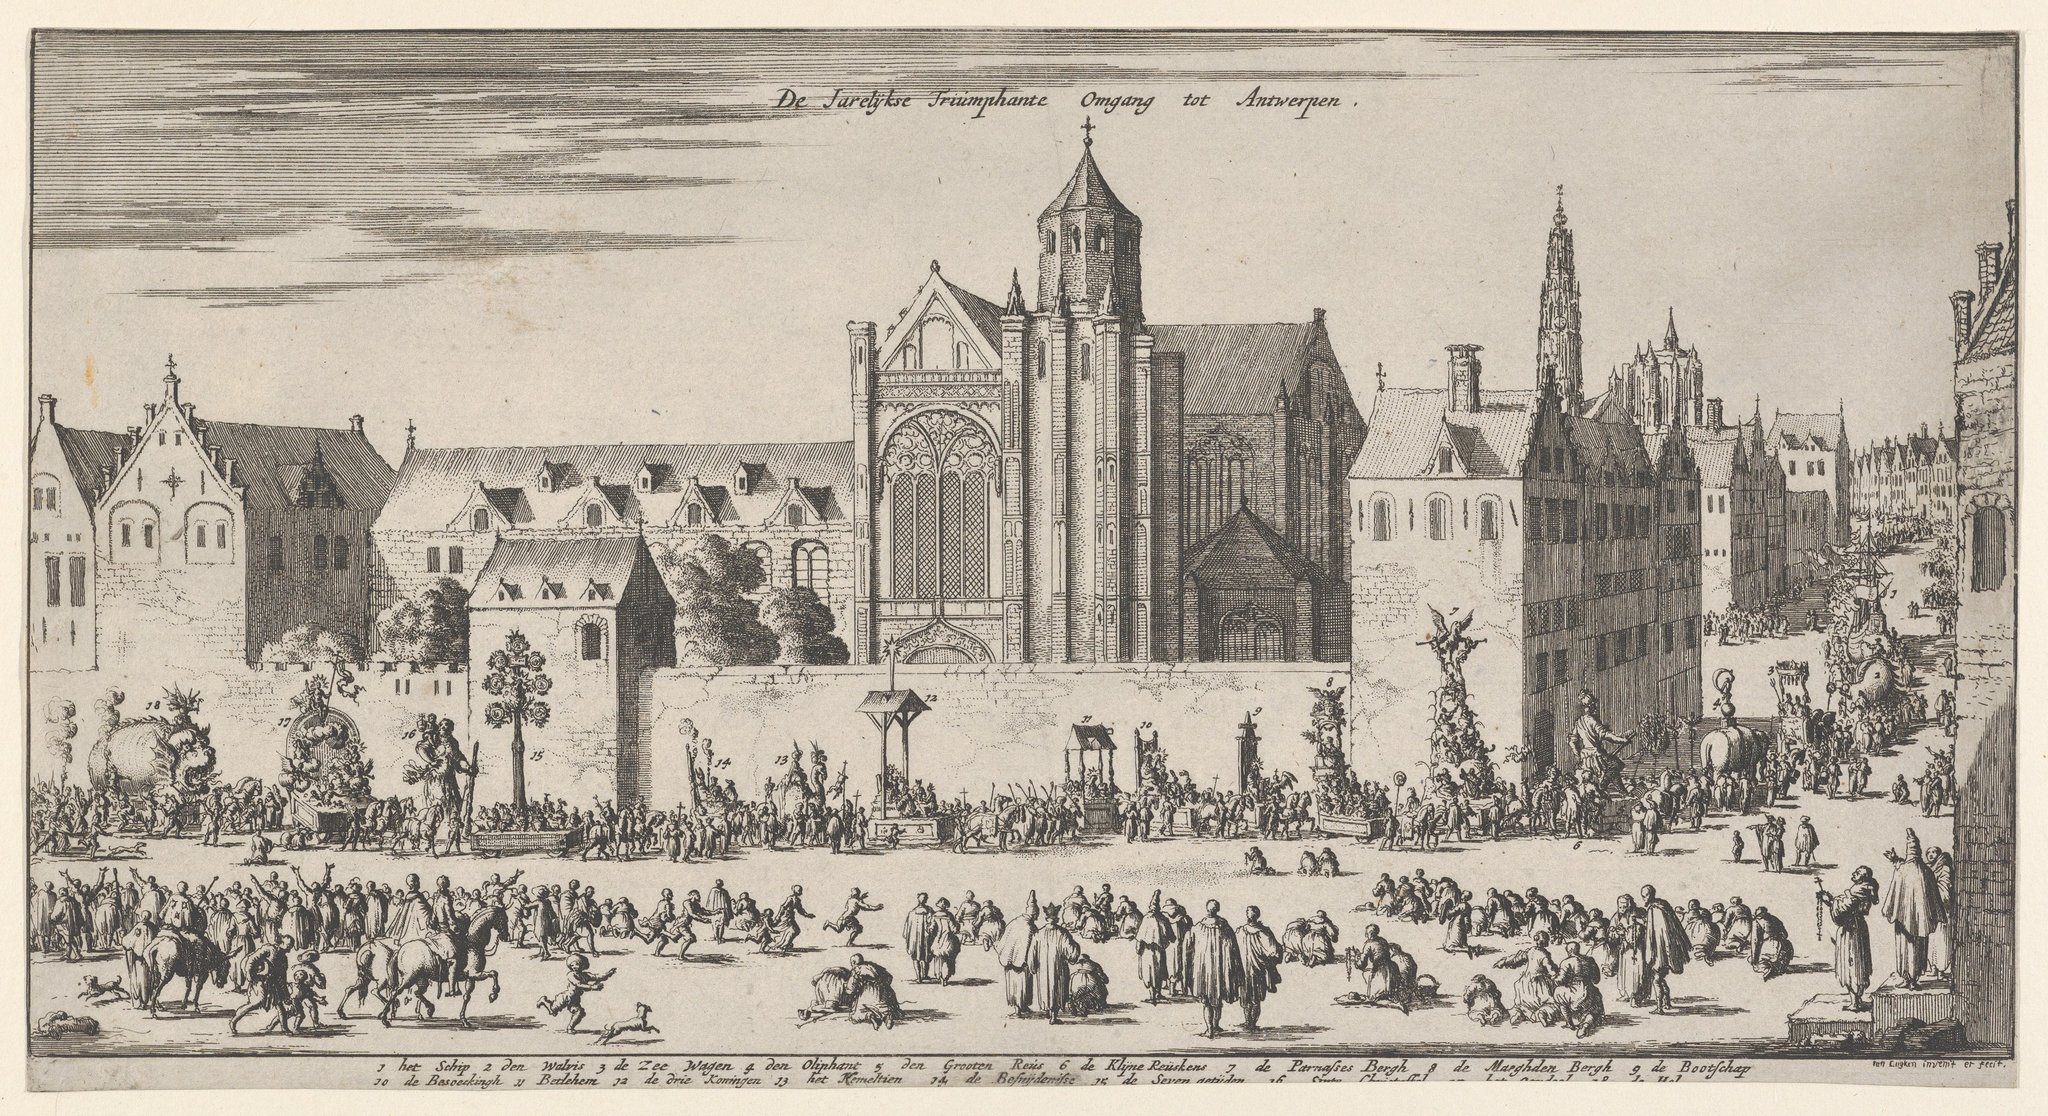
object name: print, fete, ornament architecture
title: Triumphal procession to Antwerp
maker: jan luyken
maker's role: artist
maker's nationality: dutch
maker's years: 1649-1712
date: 1684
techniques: etching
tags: churches,crowd